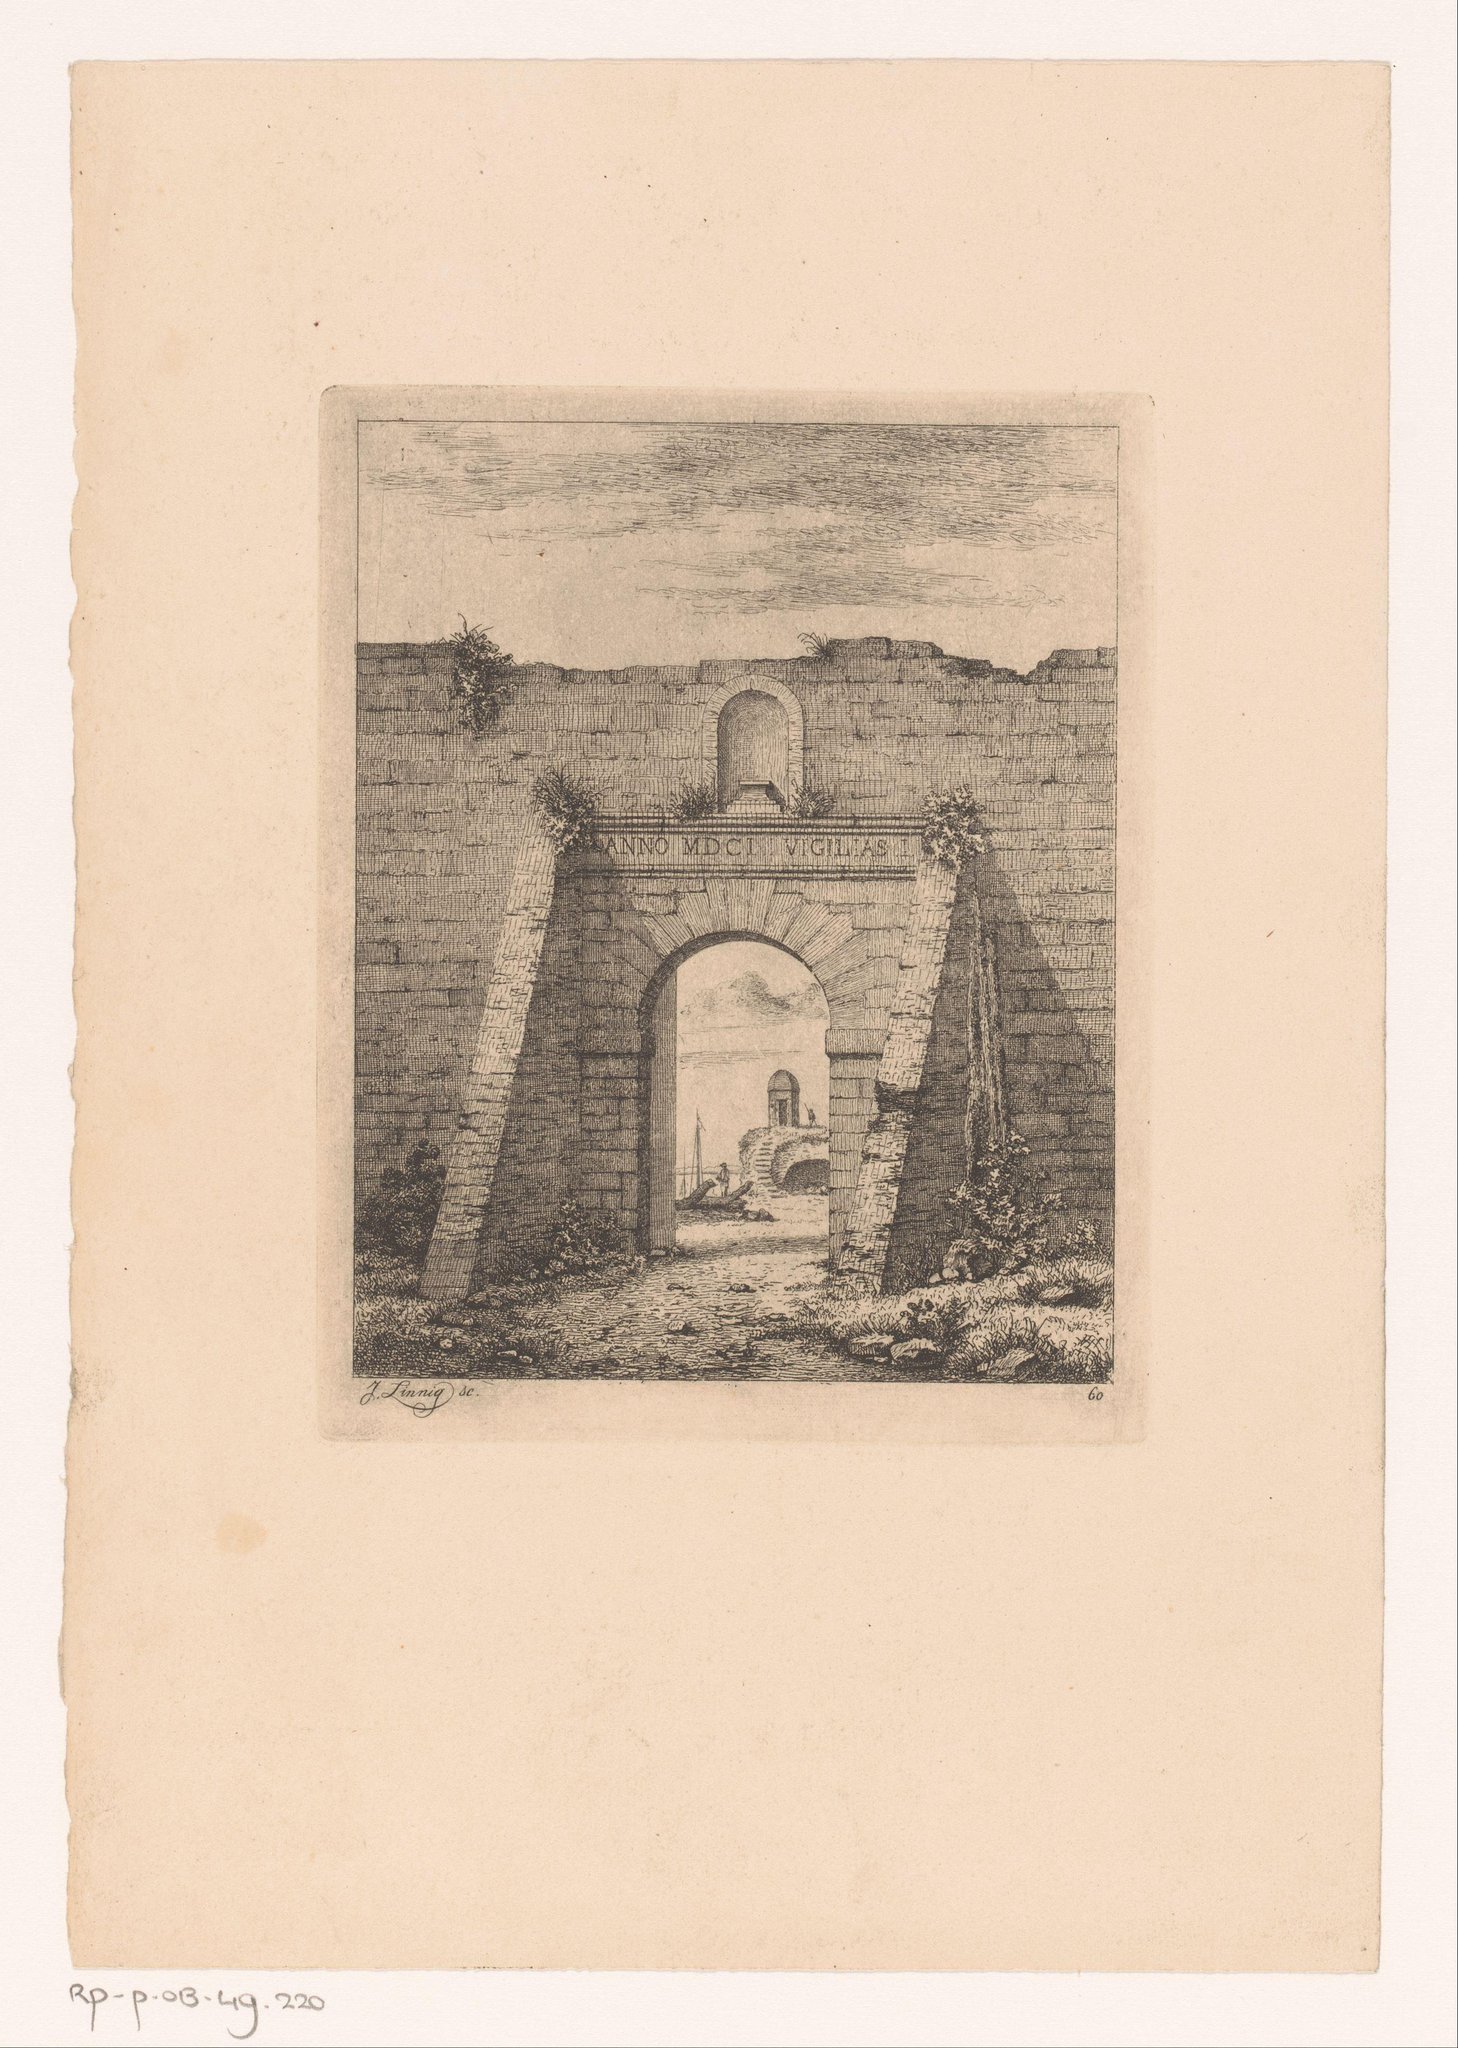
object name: book illustration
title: Poort in de stadsmuur van Sint-Laureins in Antwerpen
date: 1868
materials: paper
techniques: etching, intaglio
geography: antwerp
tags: city-gate, antwerp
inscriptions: collector's mark: Lugt 2228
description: Prent uit: Mertens, F.H. Album historique de la ville d'Anvers [...]. Antwerpen: J.E. Buschmann, 1868.